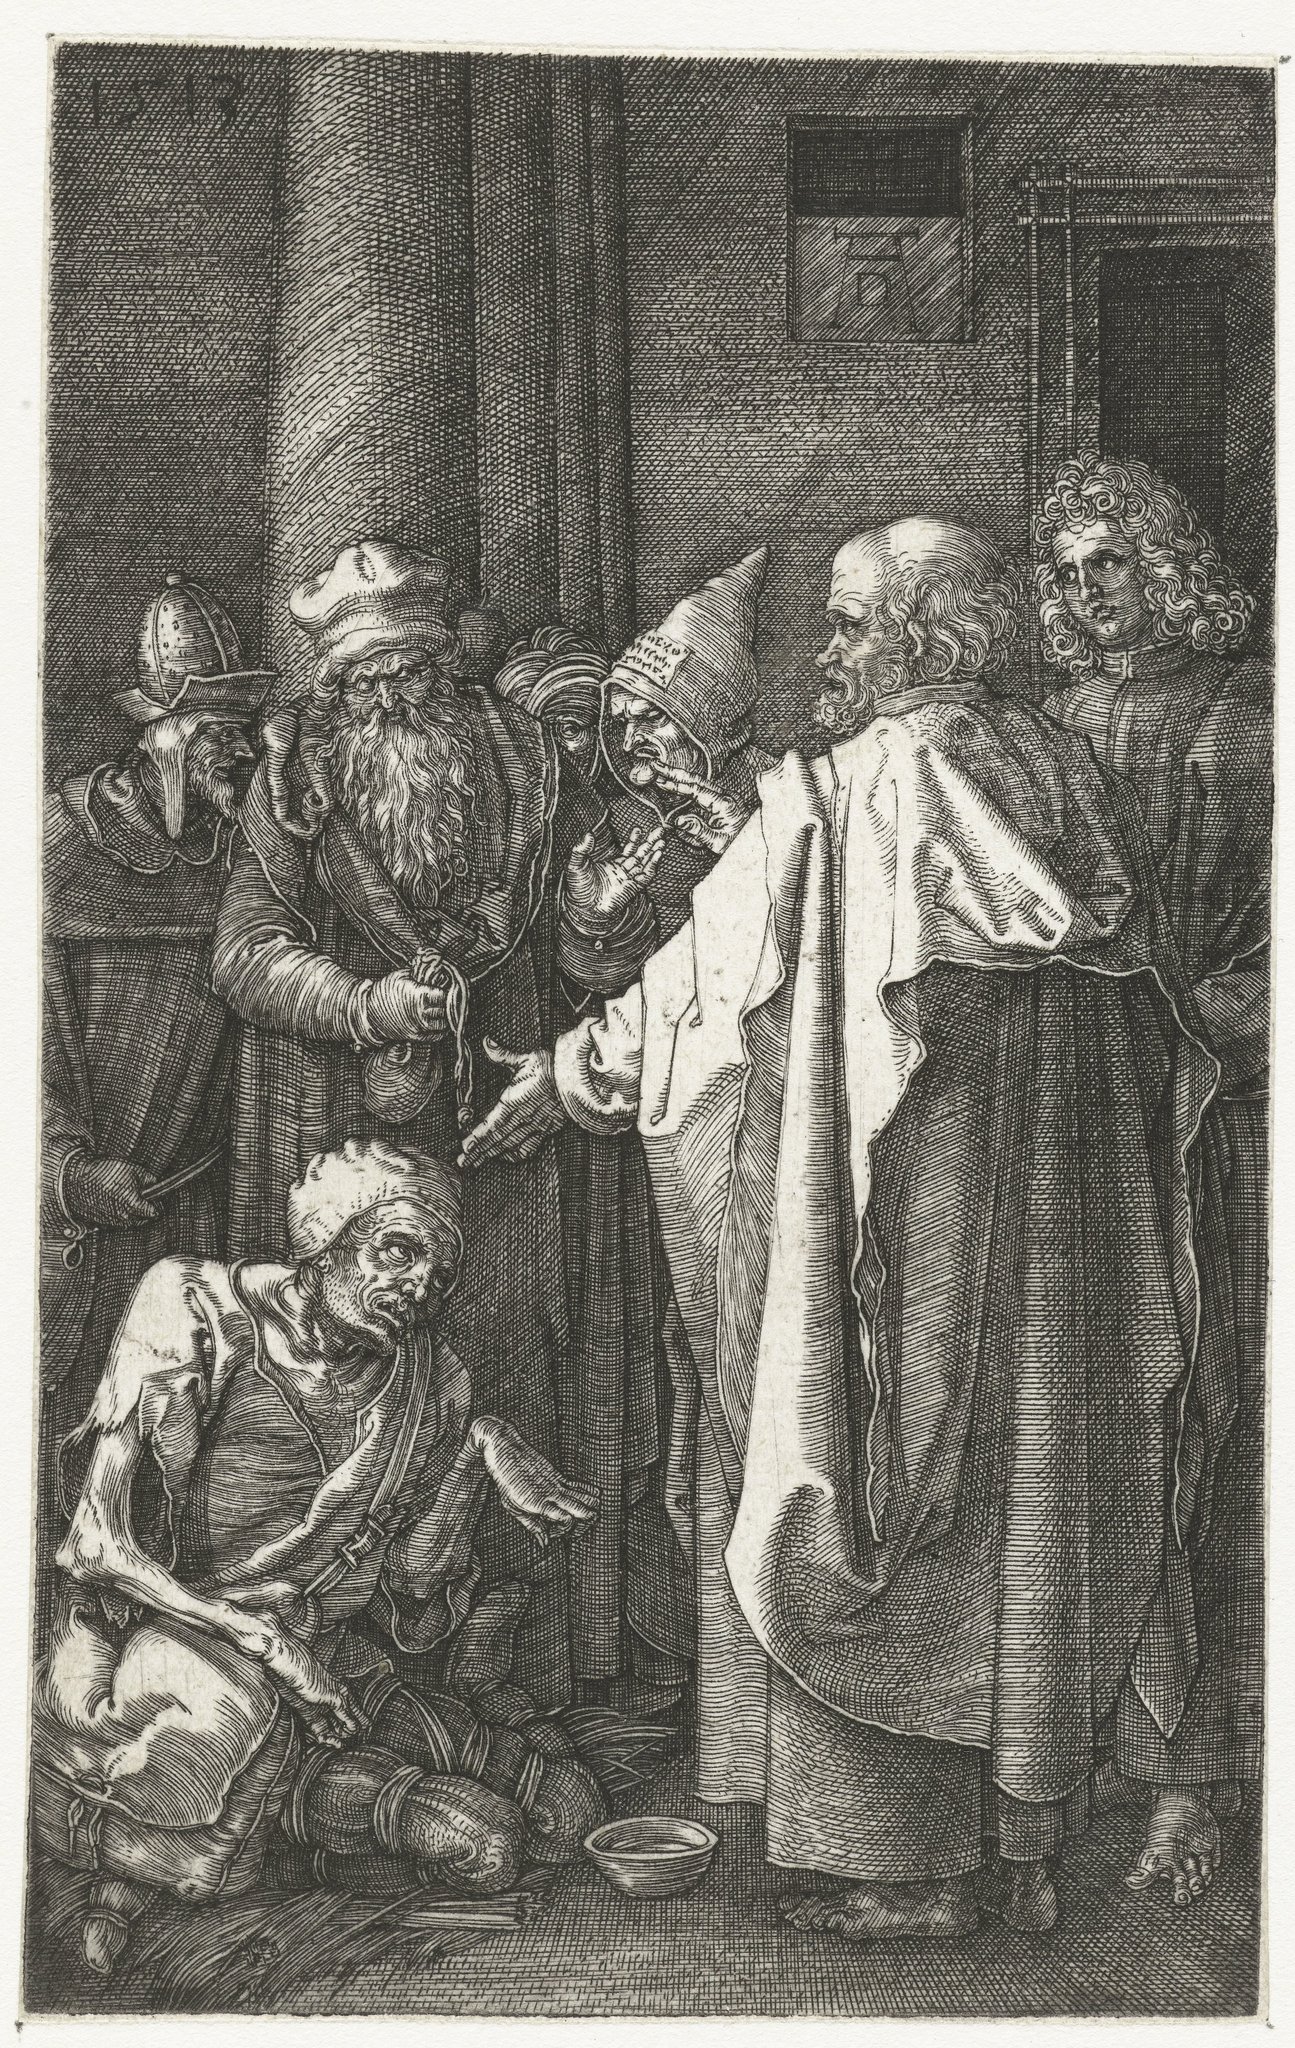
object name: print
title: De gegraveerde Passie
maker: albrecht dürer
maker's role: draughtsman, painter, print maker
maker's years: 1471-1528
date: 1513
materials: paper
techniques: engraving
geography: nuremberg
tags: healing of a lame beggar at the beautiful gate of the temple by peter and john (acts 3 - 4:31), disabilities, deformations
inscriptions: collector's mark: Lugt 2228a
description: De apostelen Petrus en Johannes de evangelist staan bij een kreupele man. Petrus steekt zijn hand naar hem uit. Op de achtergrond nog een aantal mannen. Deze prent is onderdeel van een serie van 16 prenten met scènes uit het Lijdensverhaal.